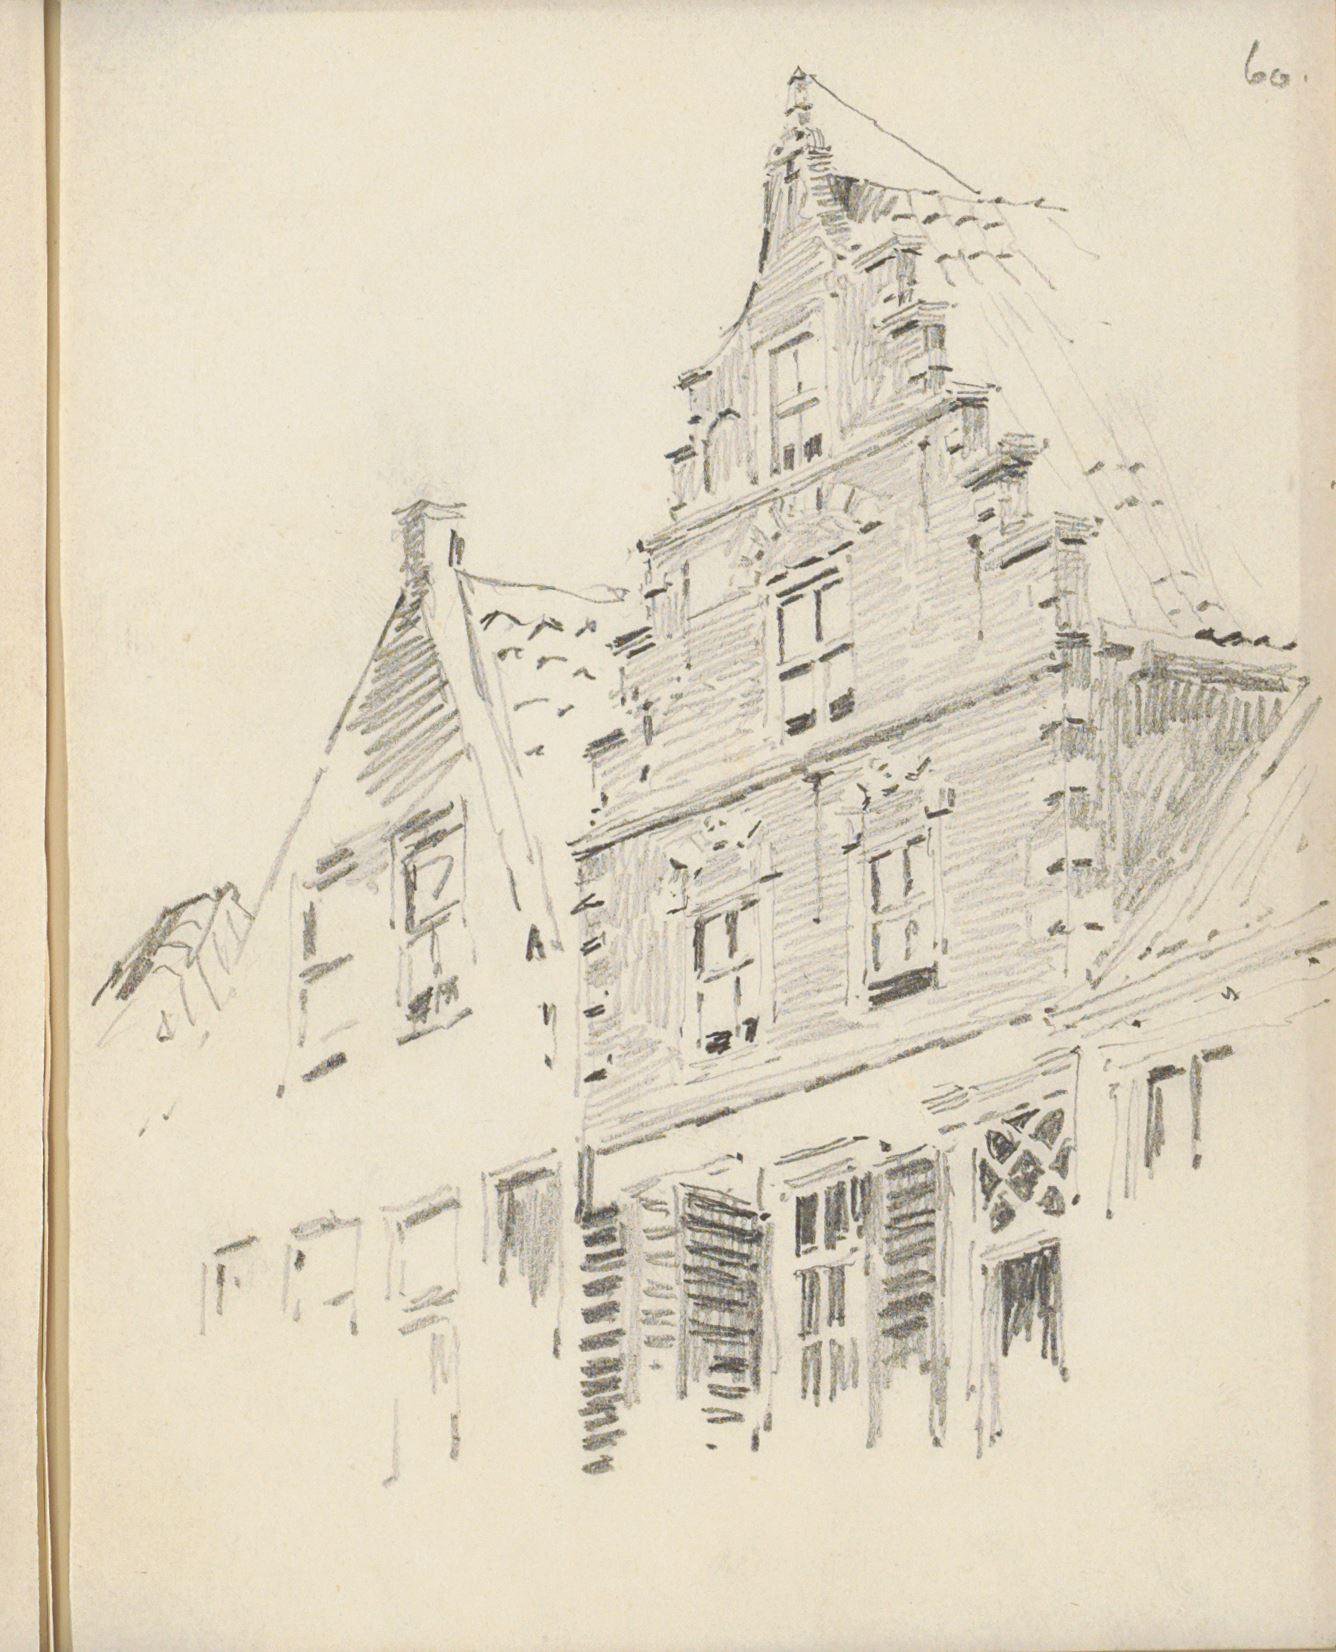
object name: sketchbook leaf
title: Rijtjeshuizen met een tuit- en trapgevel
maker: alfred william rich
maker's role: draughtsman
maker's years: 1856-1921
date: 1892-1893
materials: paper, pencil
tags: the usual house or row of houses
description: Blad 60 recto uit een schetsboek met 86 bladen.